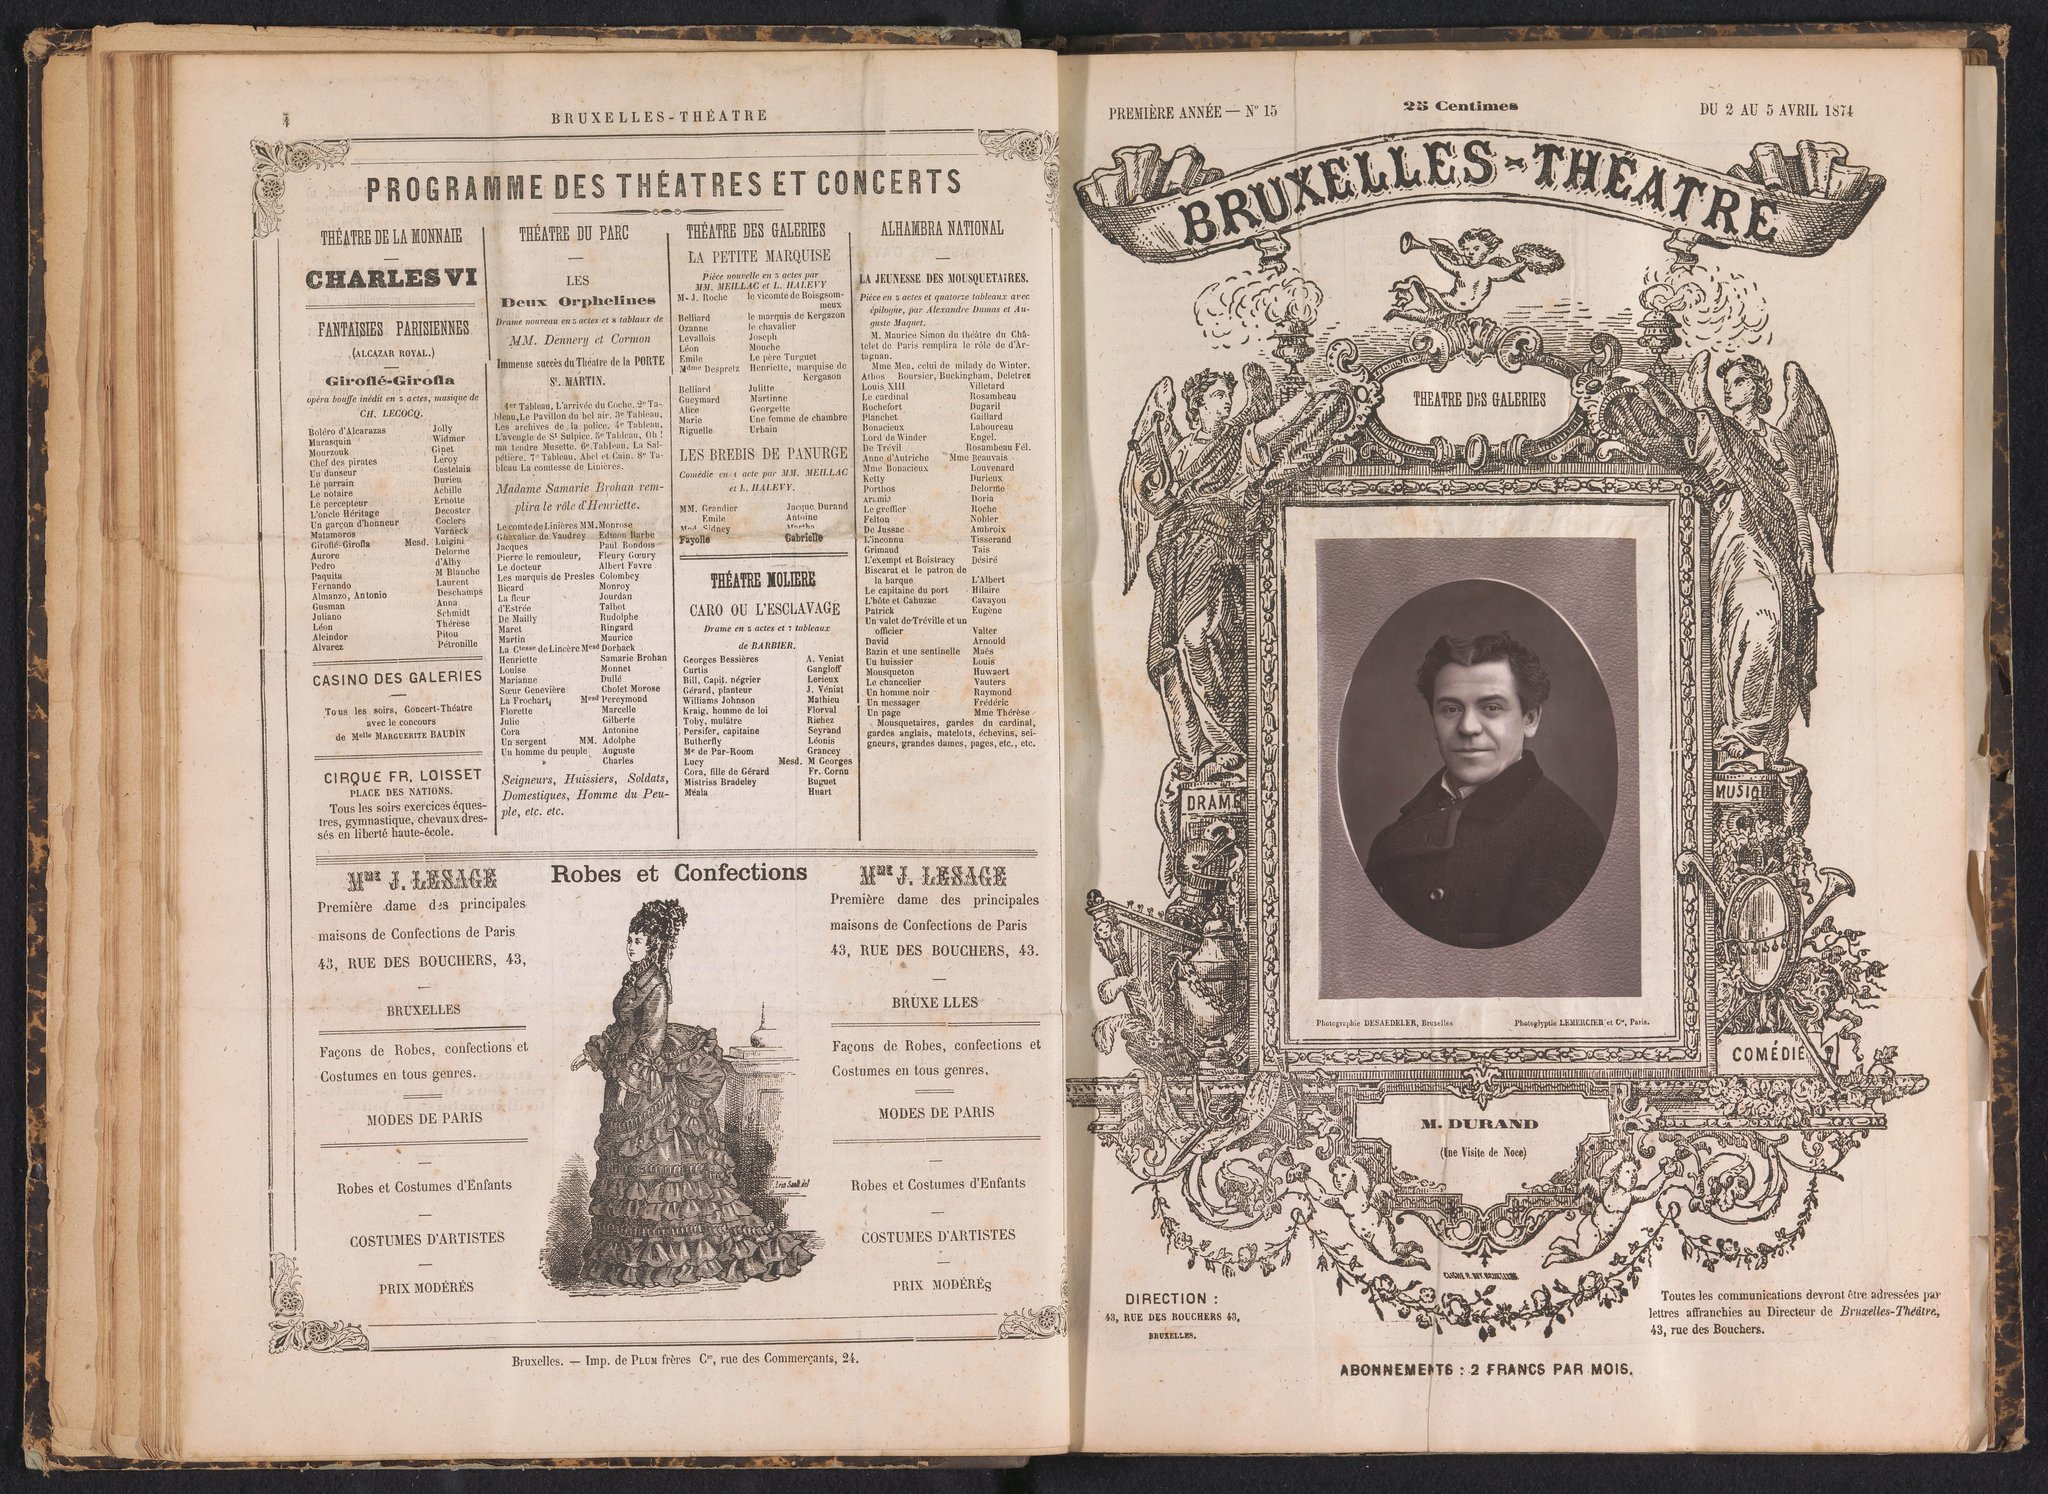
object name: page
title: M. Durand (Une visite de Noce)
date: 1869-1874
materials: paper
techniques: woodburytype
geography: brussels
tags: portrait of actor, actress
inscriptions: number: ‘No 15’